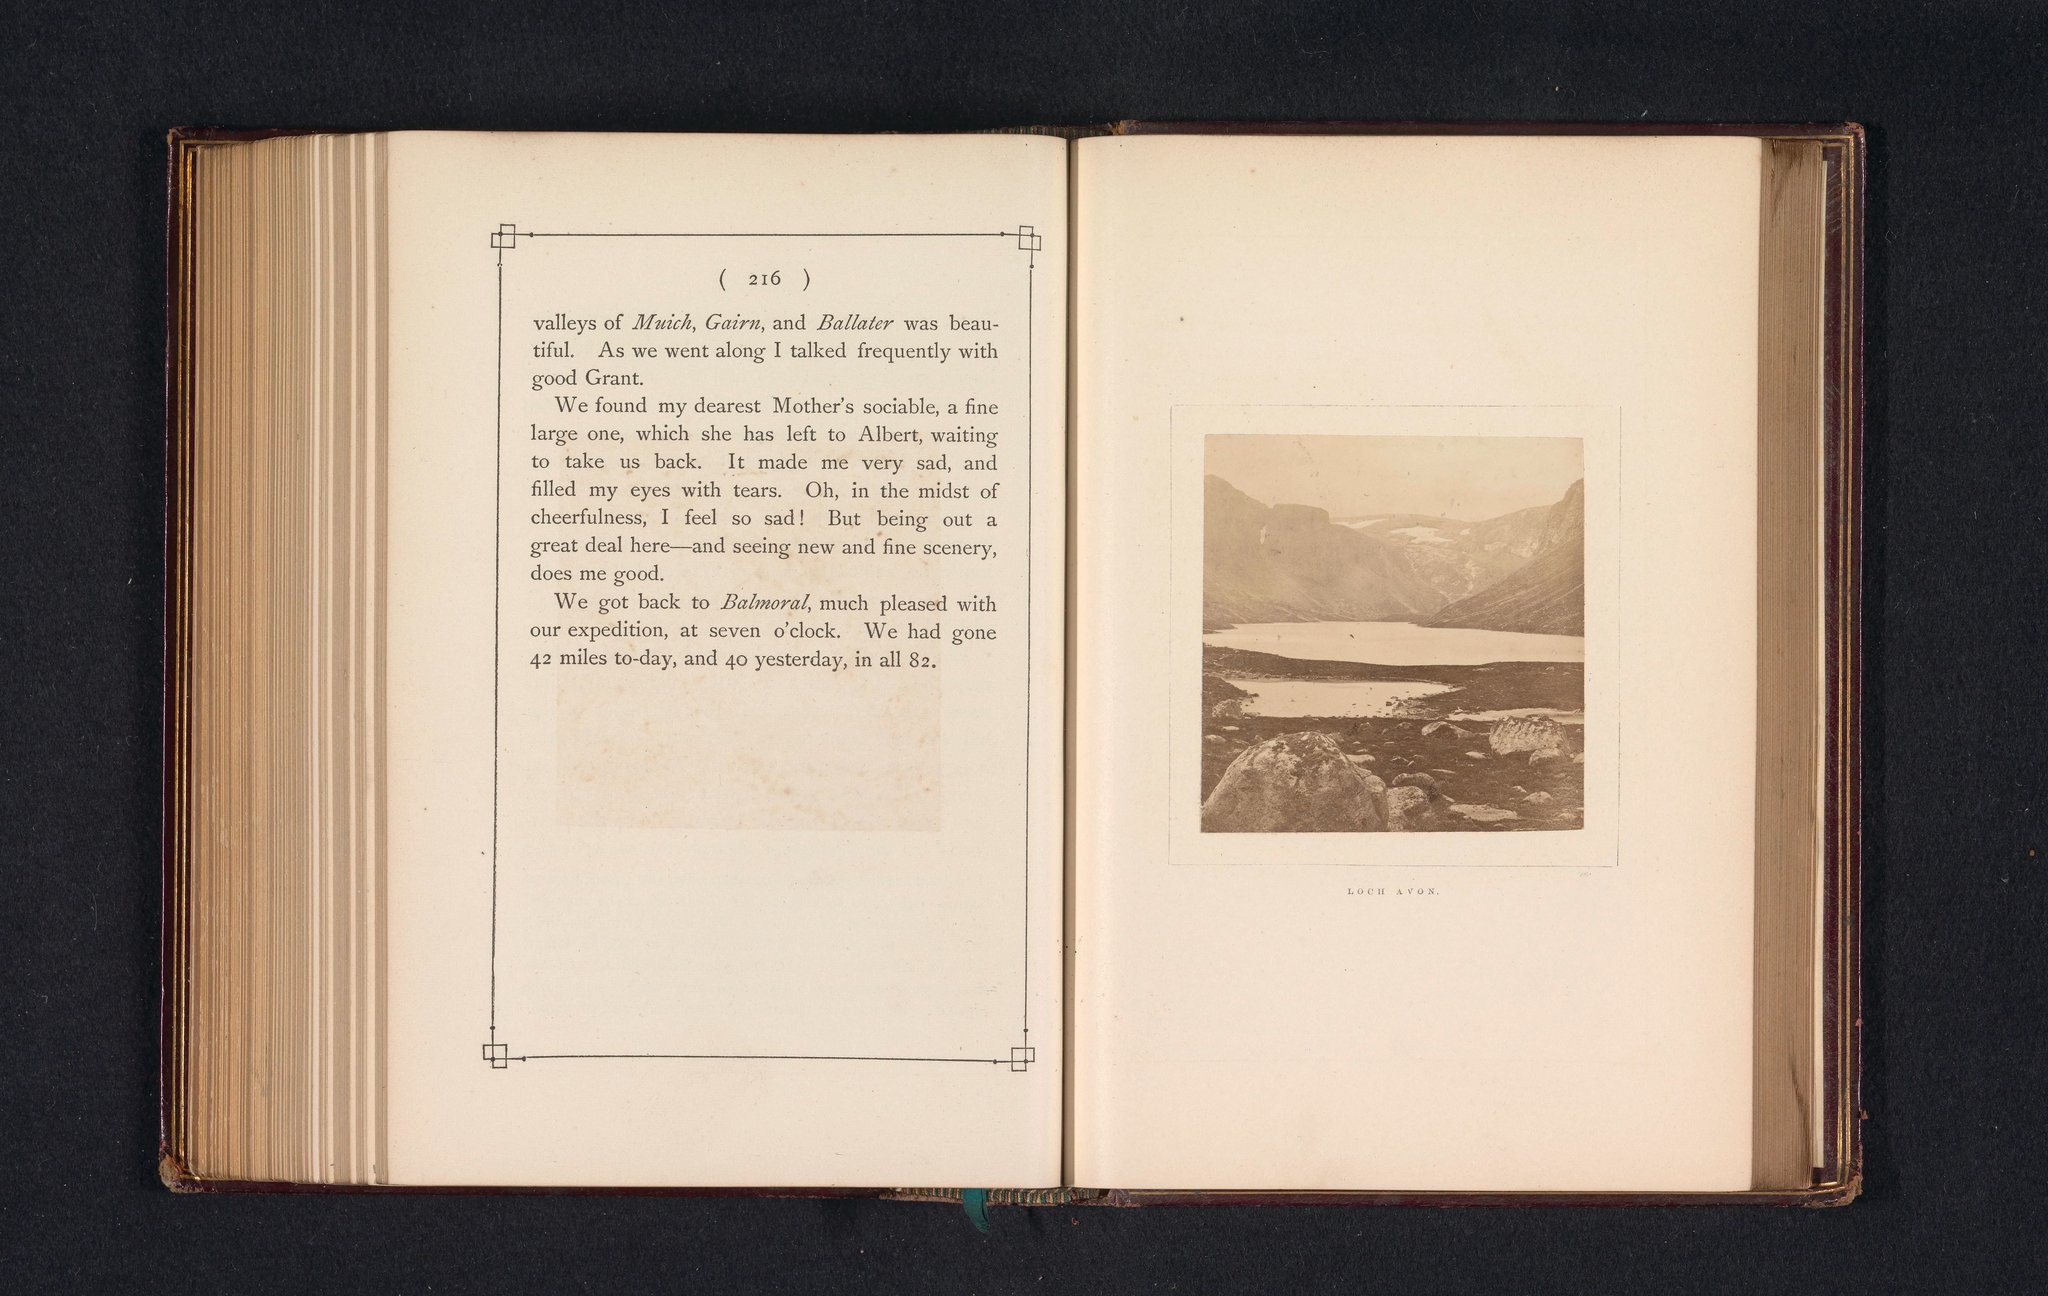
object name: page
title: Loch Avon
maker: george washington wilson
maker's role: publisher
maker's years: 1823-1893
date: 1858-1868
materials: photographic support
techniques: albumen print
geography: scotland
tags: lake, mountains